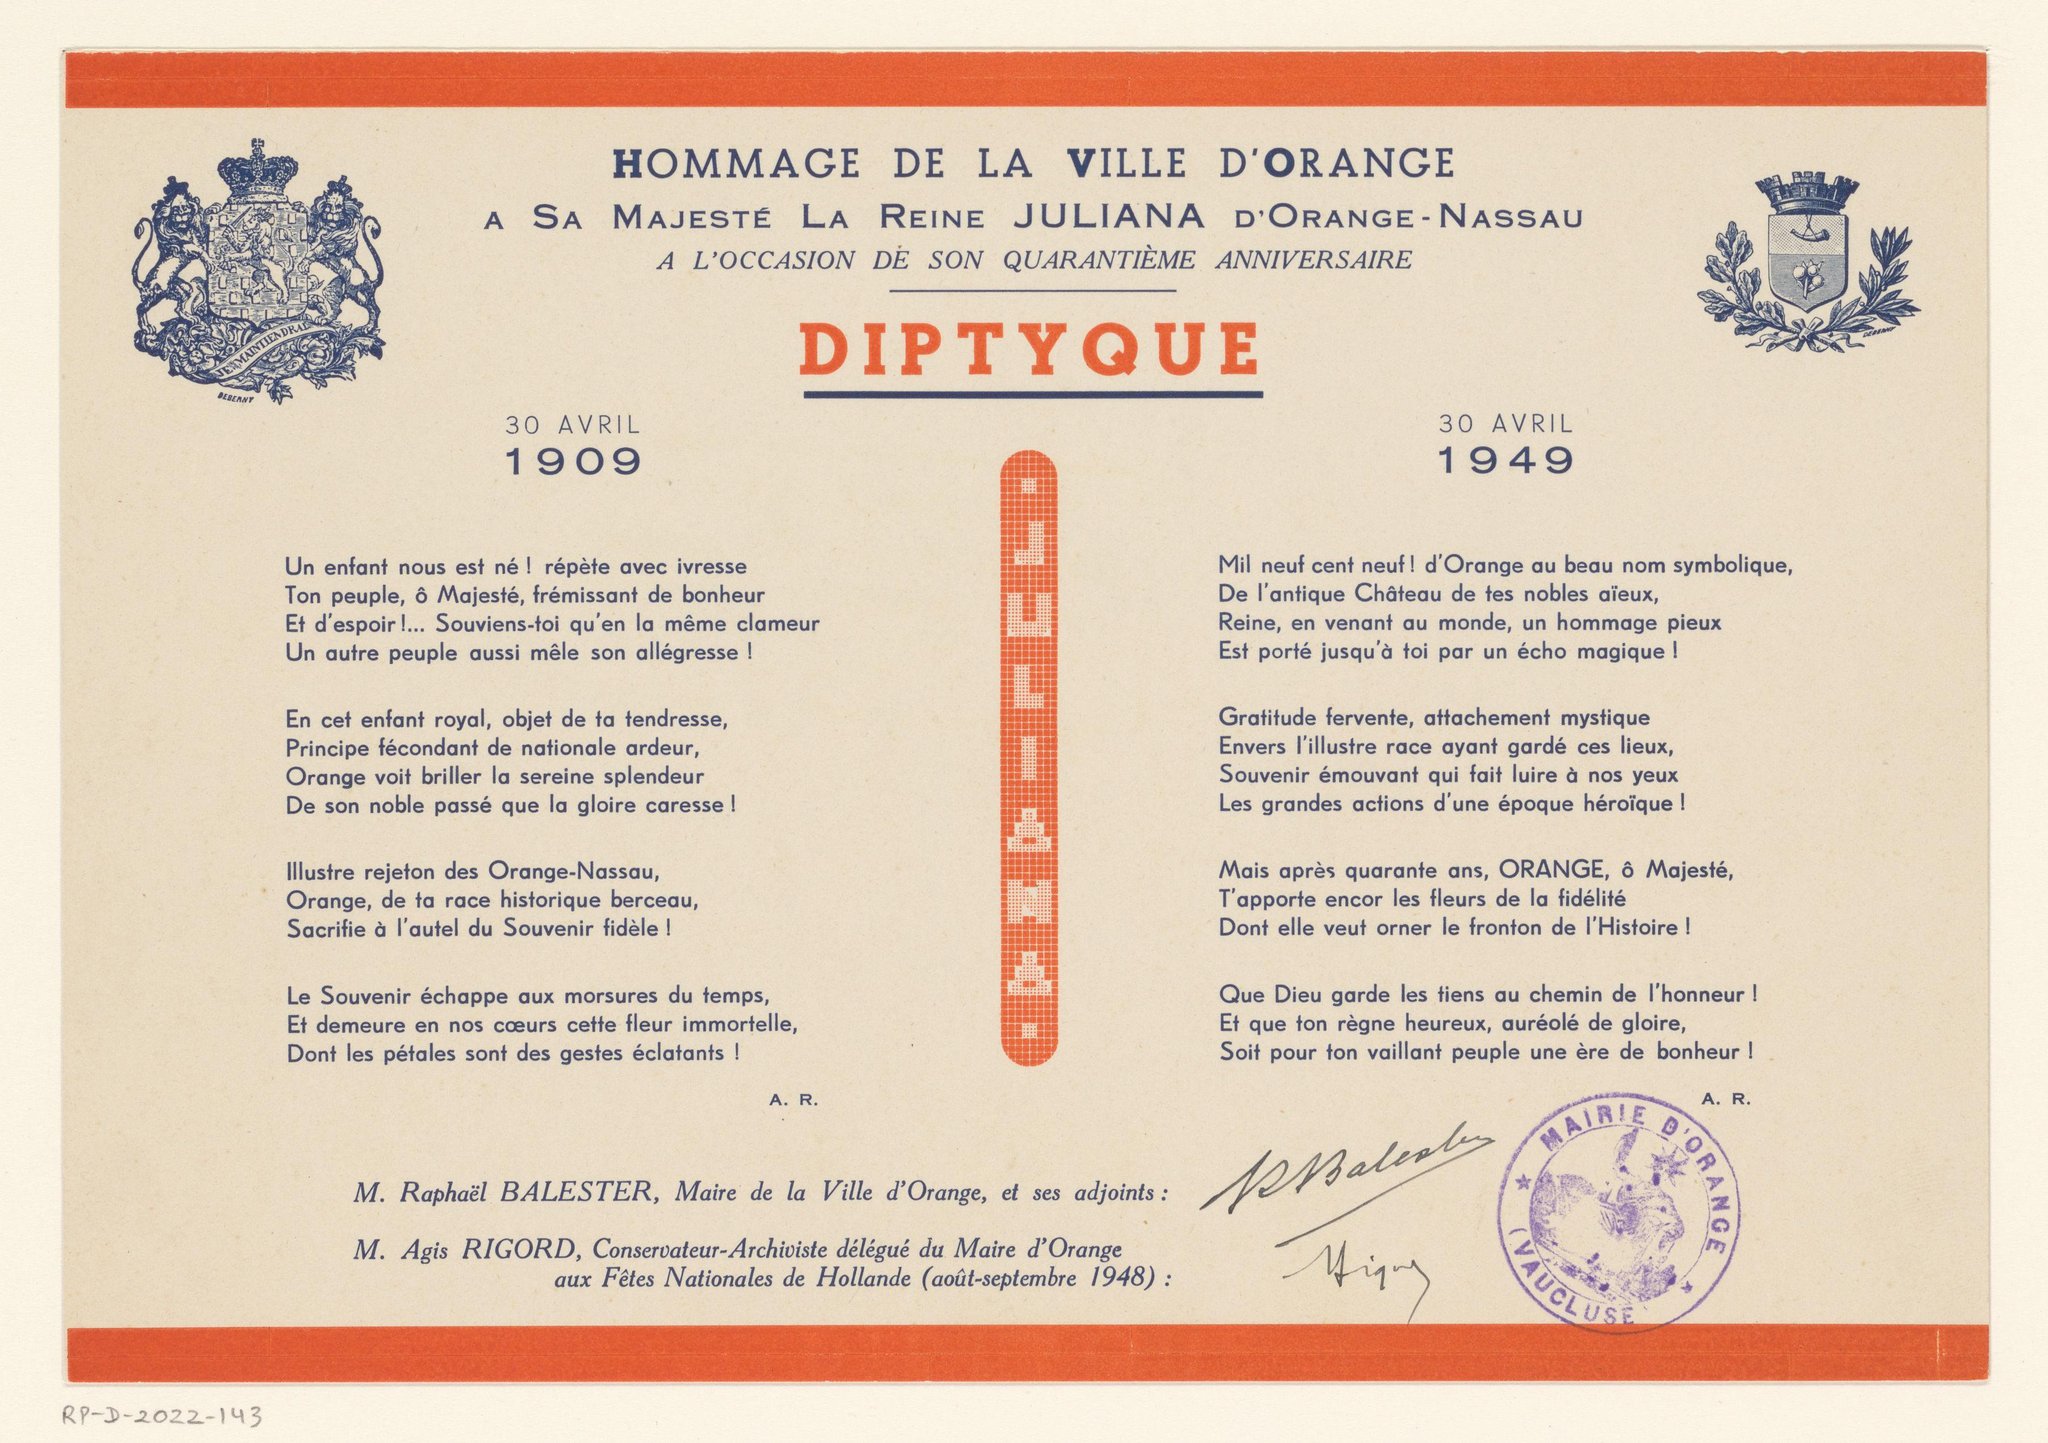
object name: text sheet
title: Hommage de la ville d'Orange a sa majesté la reine Juliana d'Orange-Nassau a l'occasion de son quarantième anniversaire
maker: Anonymous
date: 1904-1949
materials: paper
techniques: printing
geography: orange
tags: the hague, juliana of the netherlands, historical persons - bb - woman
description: Blad 'Diptyque' met twee verzen in het Frans ter gelegenheid van de veertigste verjaardag van koningin Juliana, 30 april 1949. Namens het stadsbestuur van Orange. Ondertekend door de burgemeester van Orange en de conservator van de 'Fêtes Nationales de Hollande'. Bovenaan twee wapens van Nederland en van Orange, rechtsonder de stempel van de burgemeester.